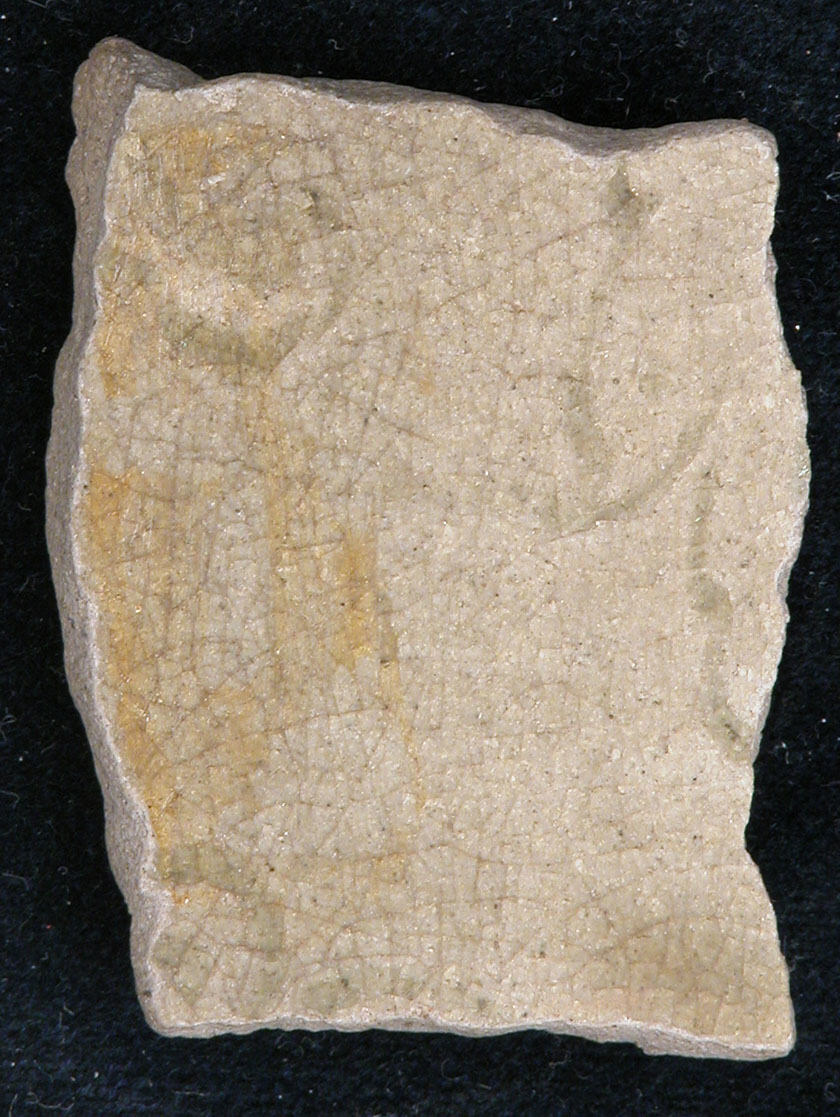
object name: fragment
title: Ceramic Fragment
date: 1101-1300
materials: stonepaste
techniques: glazing, painting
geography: saudi arabia